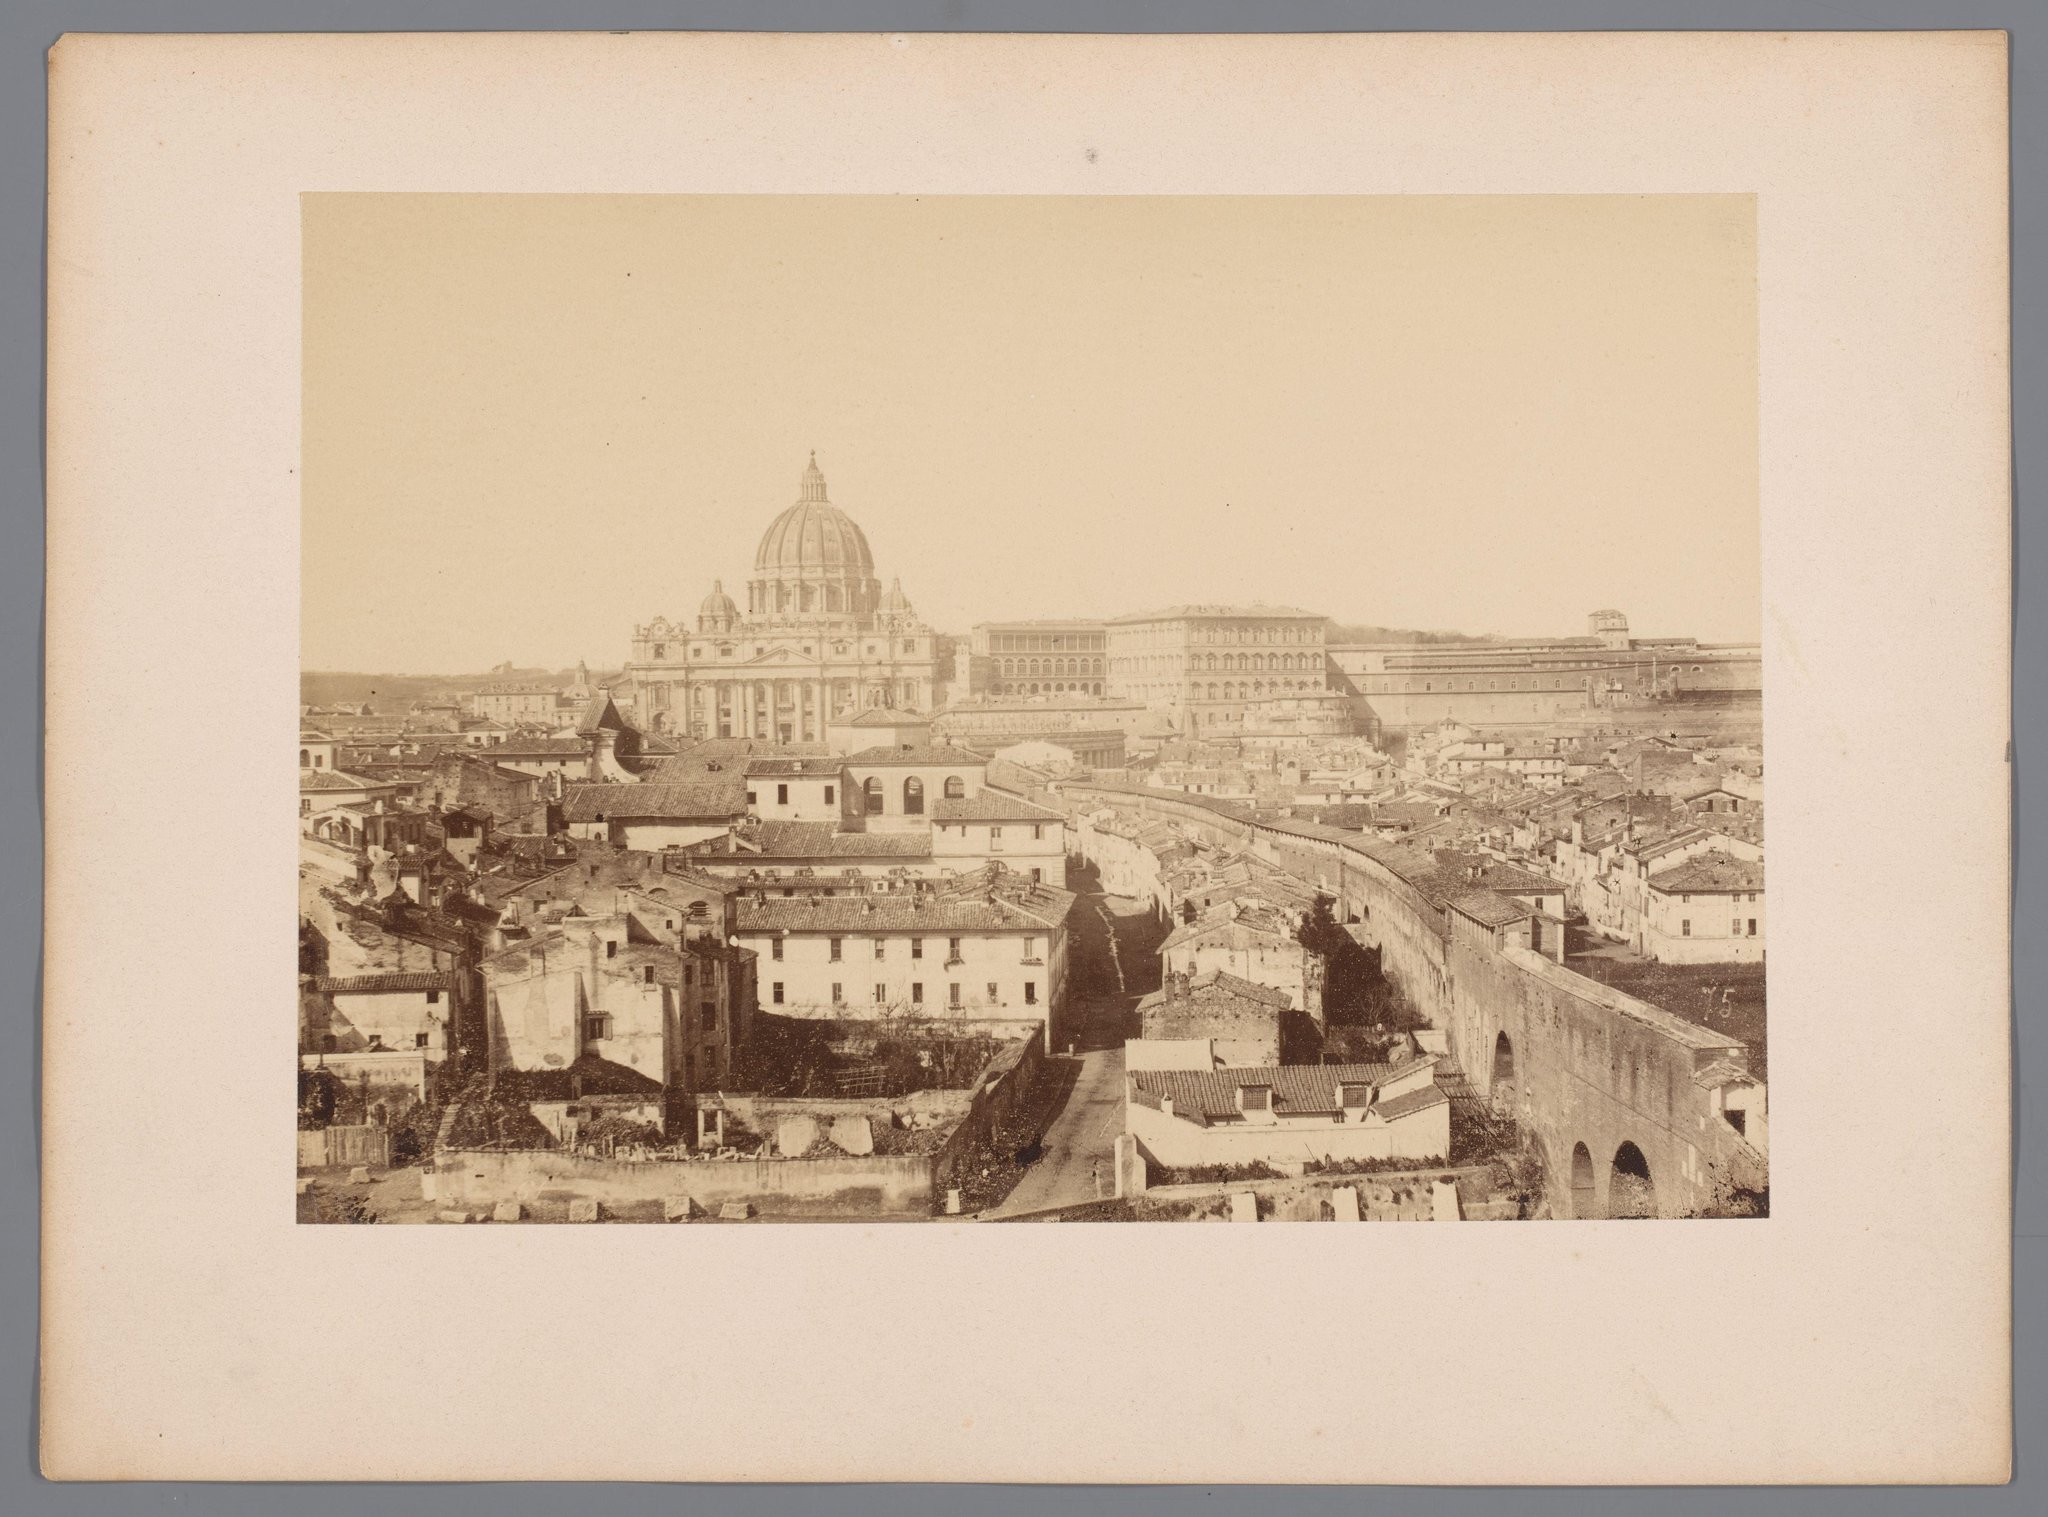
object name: photograph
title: Gezicht op de Sint-Pietersbasiliek en het Apostolisch Paleis te Vaticaanstad, Italië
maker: Anonymous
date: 1851-1900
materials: cardboard, paper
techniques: albumen print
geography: vatican city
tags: city-view in general; 'veduta', church (exterior), rome